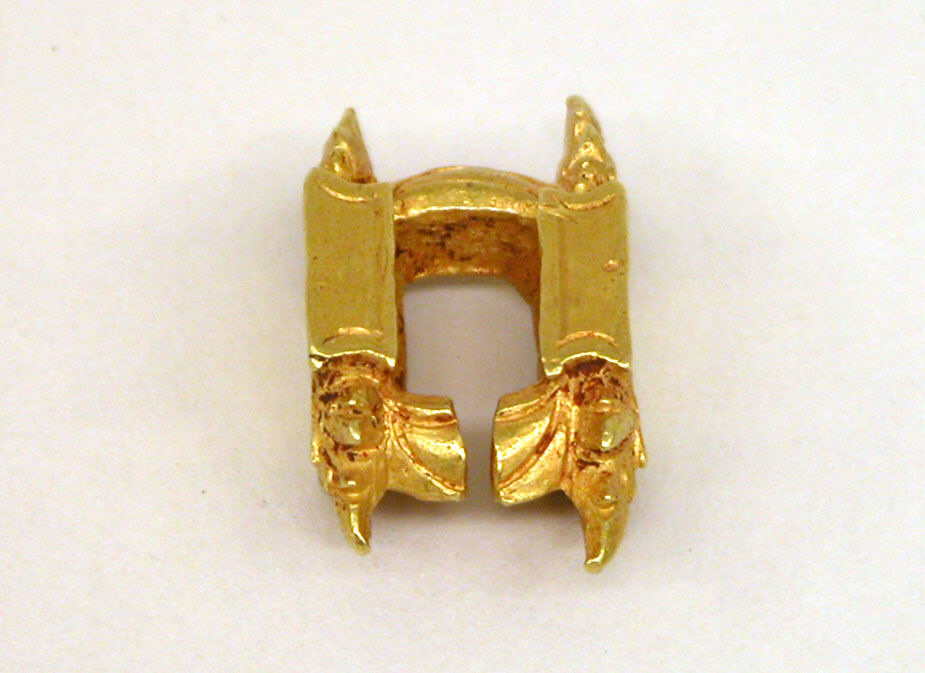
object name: ear ornament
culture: indonesian, javanese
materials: gold